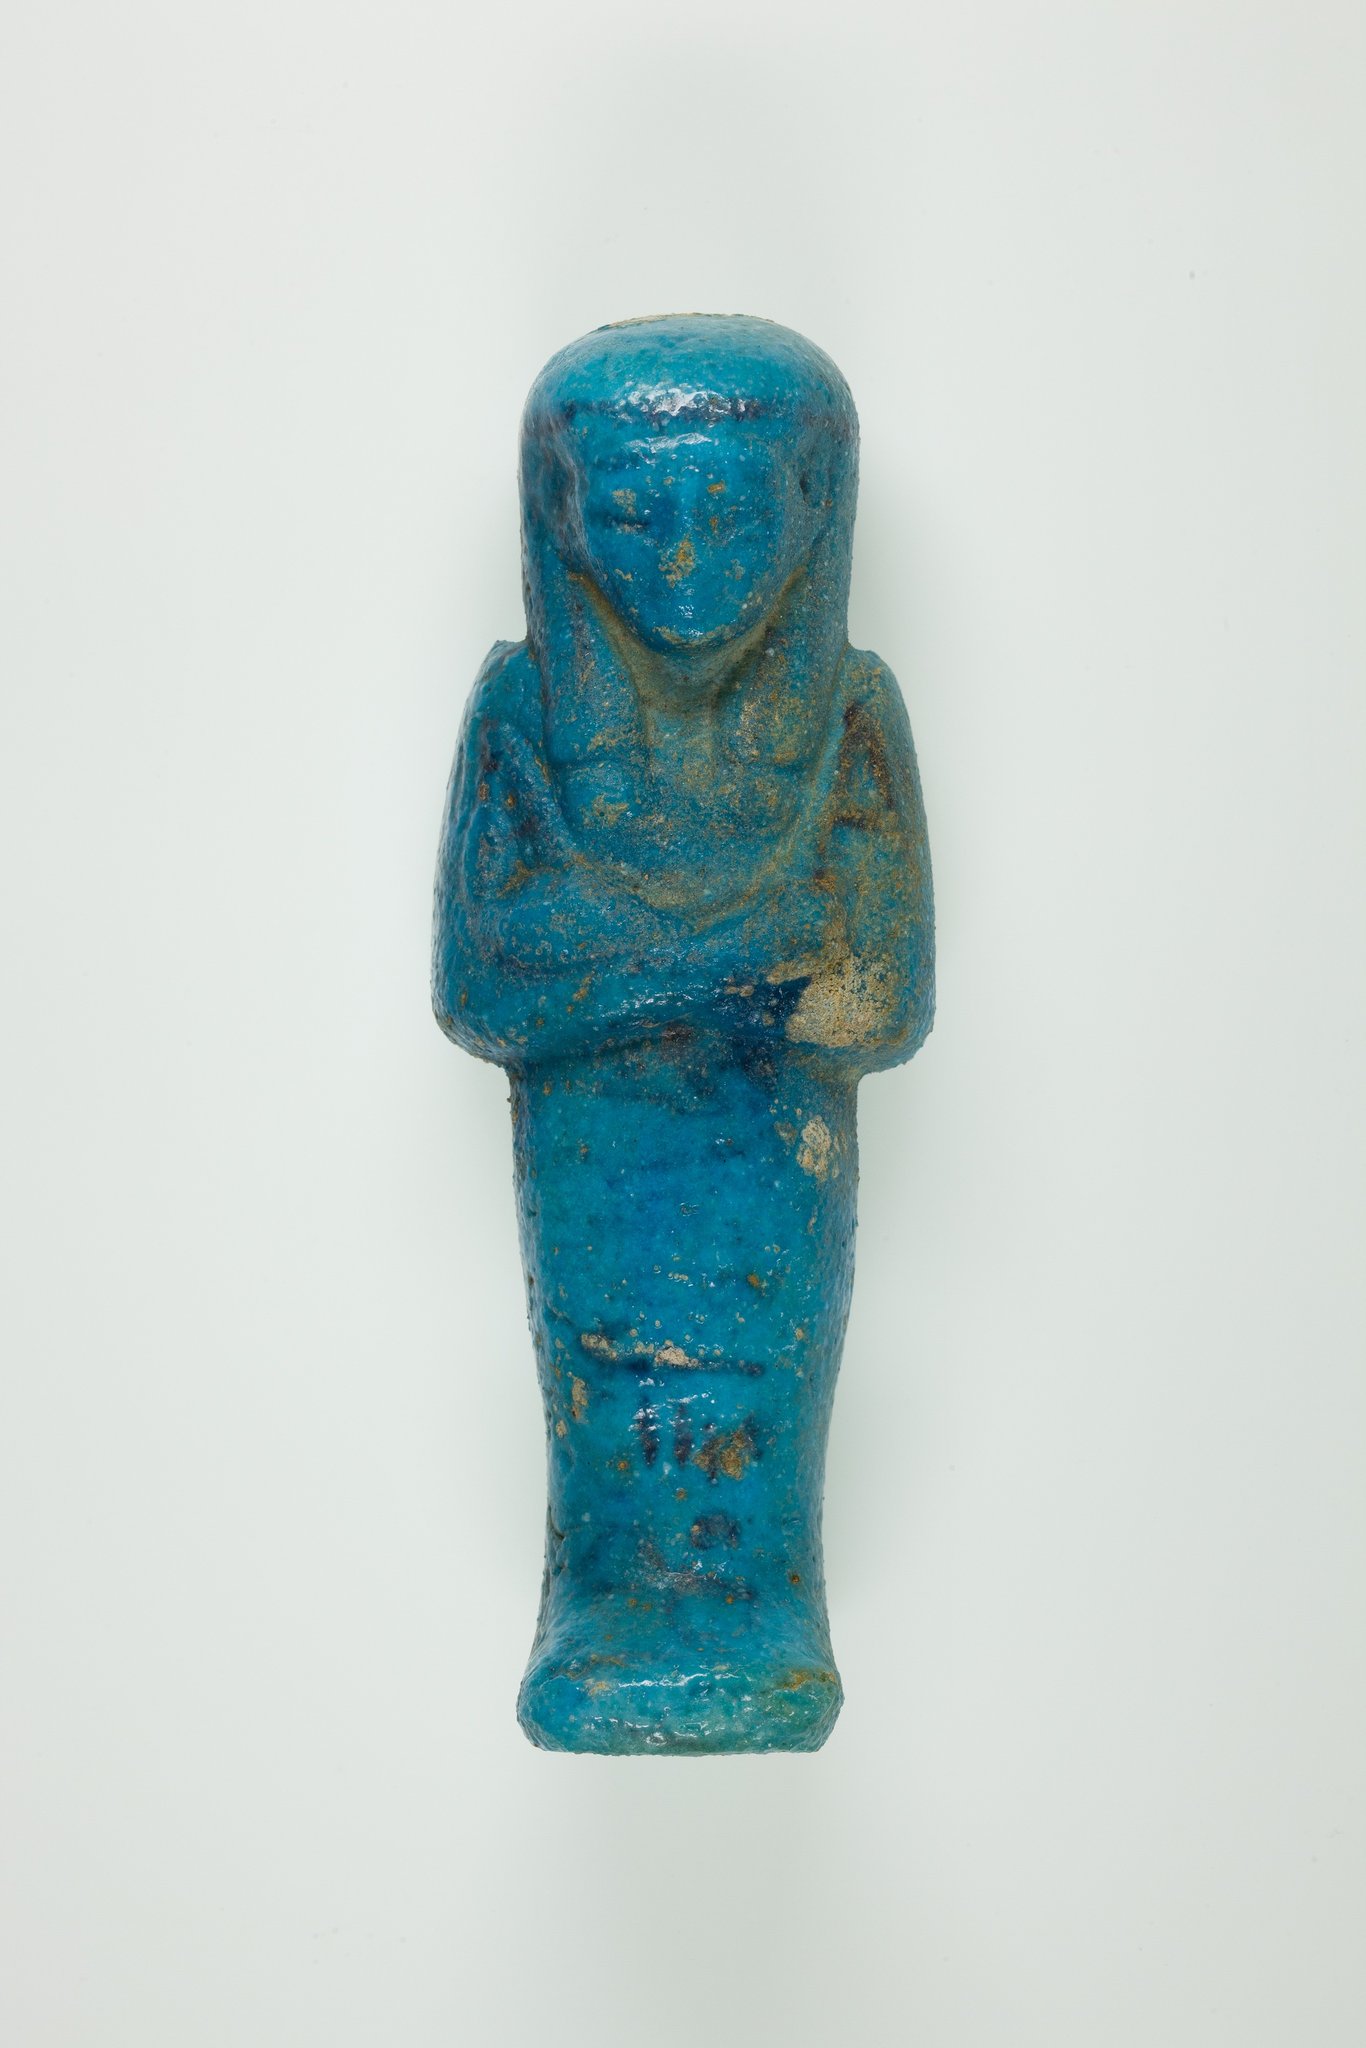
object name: worker shabti, henettawy c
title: Worker Shabti of Henettawy (C), Daughter of Isetemkheb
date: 990-970 BCE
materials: faience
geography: egypt